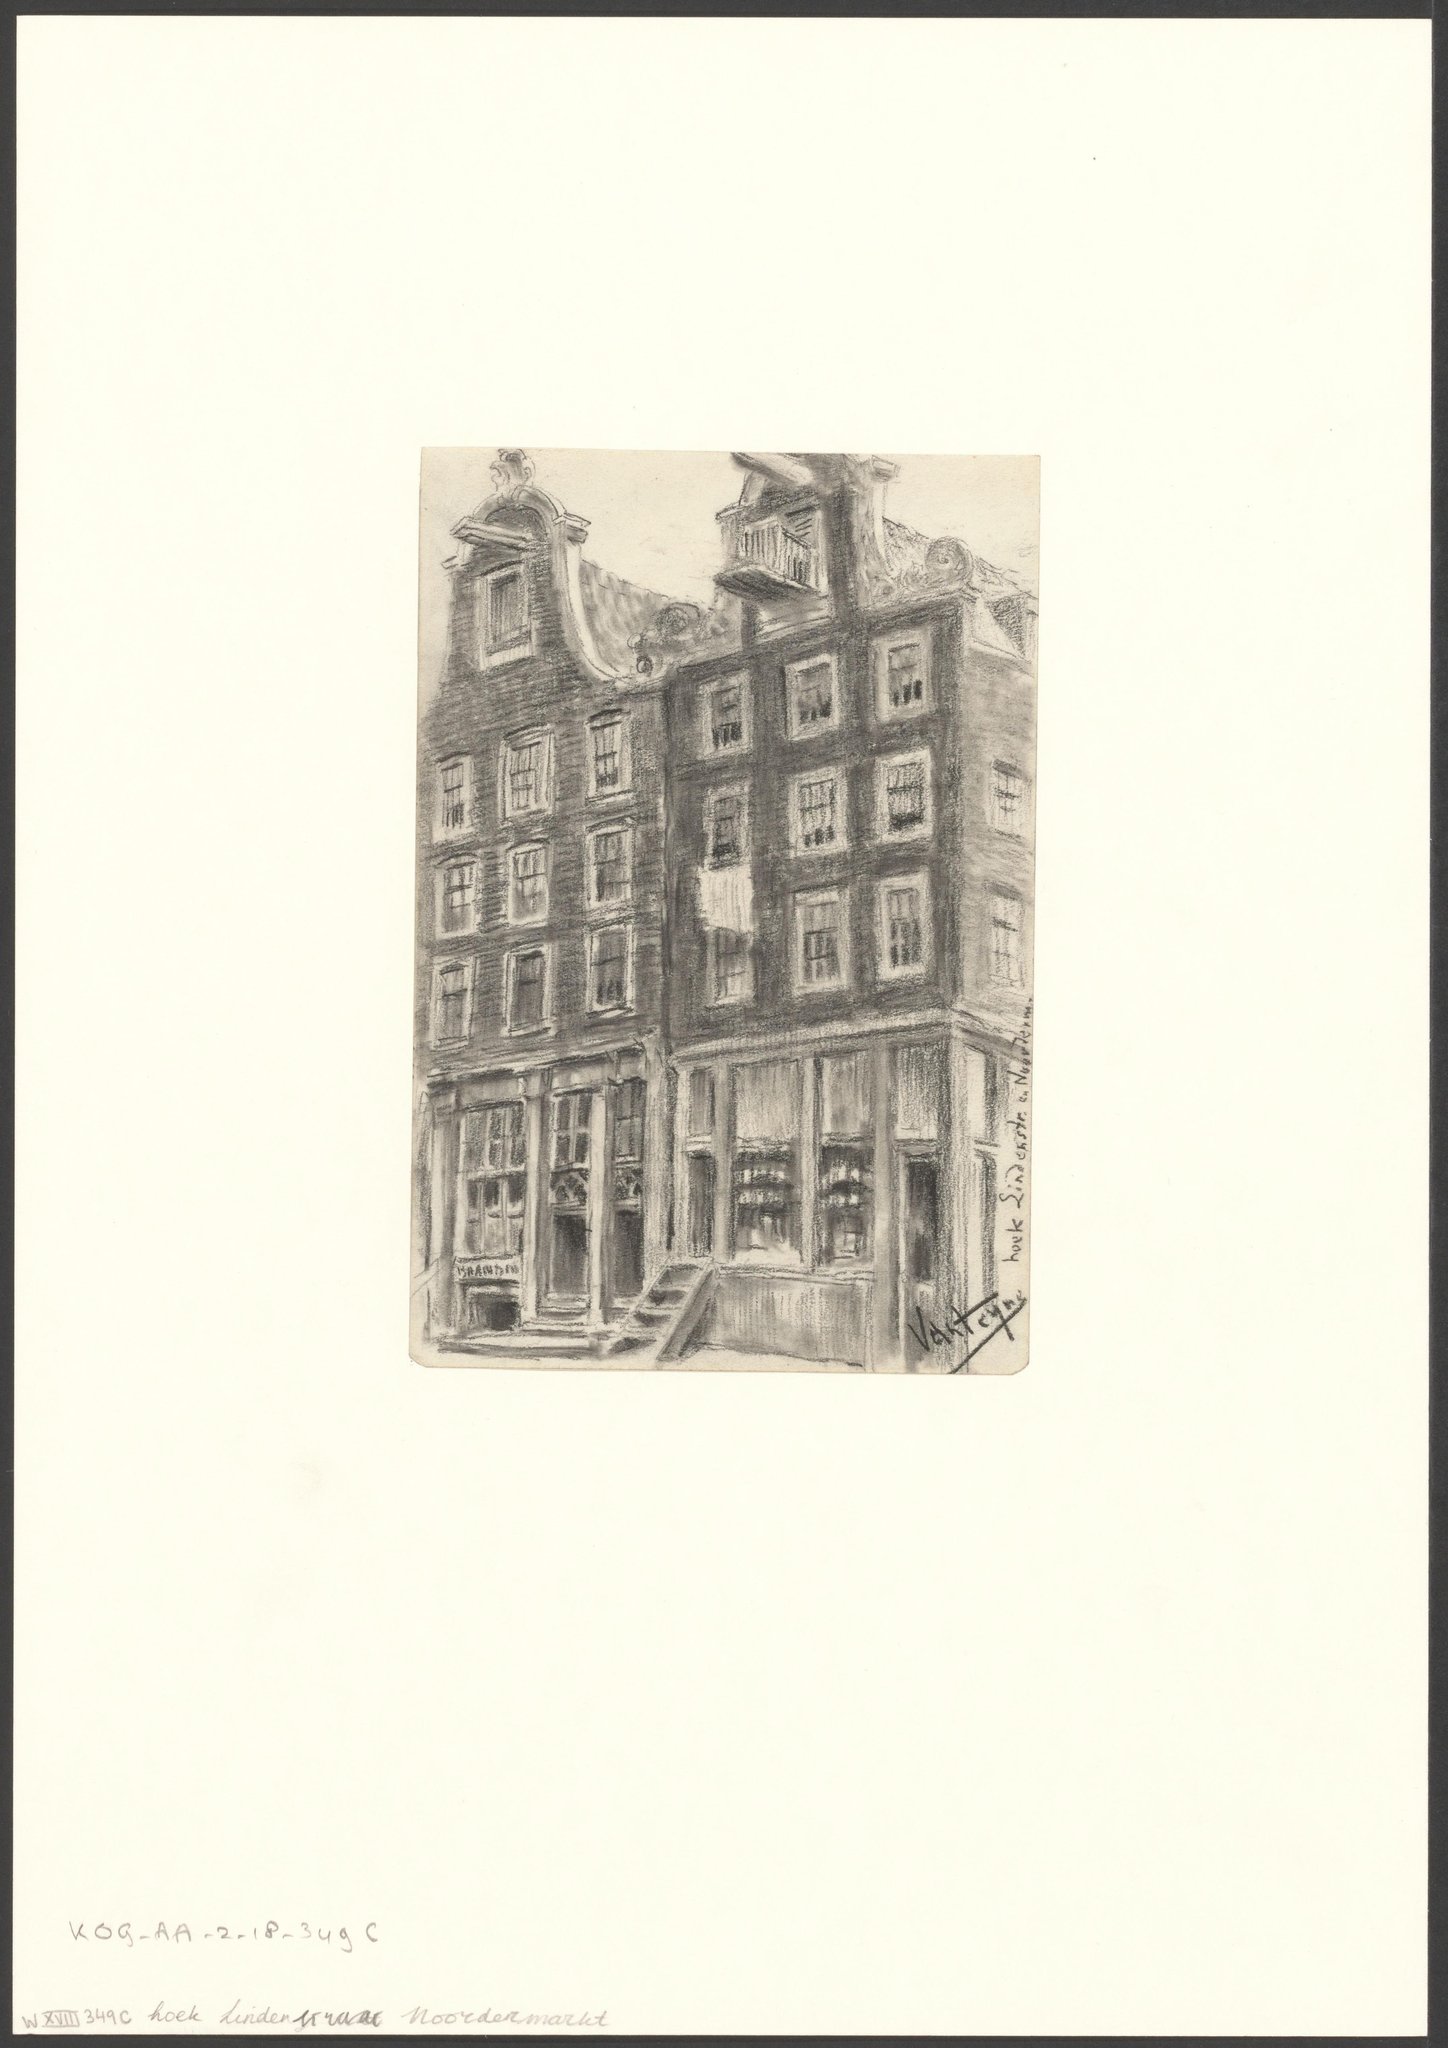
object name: drawing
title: Gezicht op de Lindenstraat, hoek Noordermarkt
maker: anthonie van teijn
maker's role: draughtsman, painter, print maker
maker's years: 1863-1943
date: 1873-1943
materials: chalk, paper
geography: amsterdam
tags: city-view in general; 'veduta', façade (of house or building)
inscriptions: signature: ‘VanTeyne’, inscription: ‘hoek Noordermarkt / en Lindenstraat’, inscription: ‘hoek Lindenstr. en Noorderm.’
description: Tekening binnen de Atlas Van Eck ingedeeld op wijknummer 18.